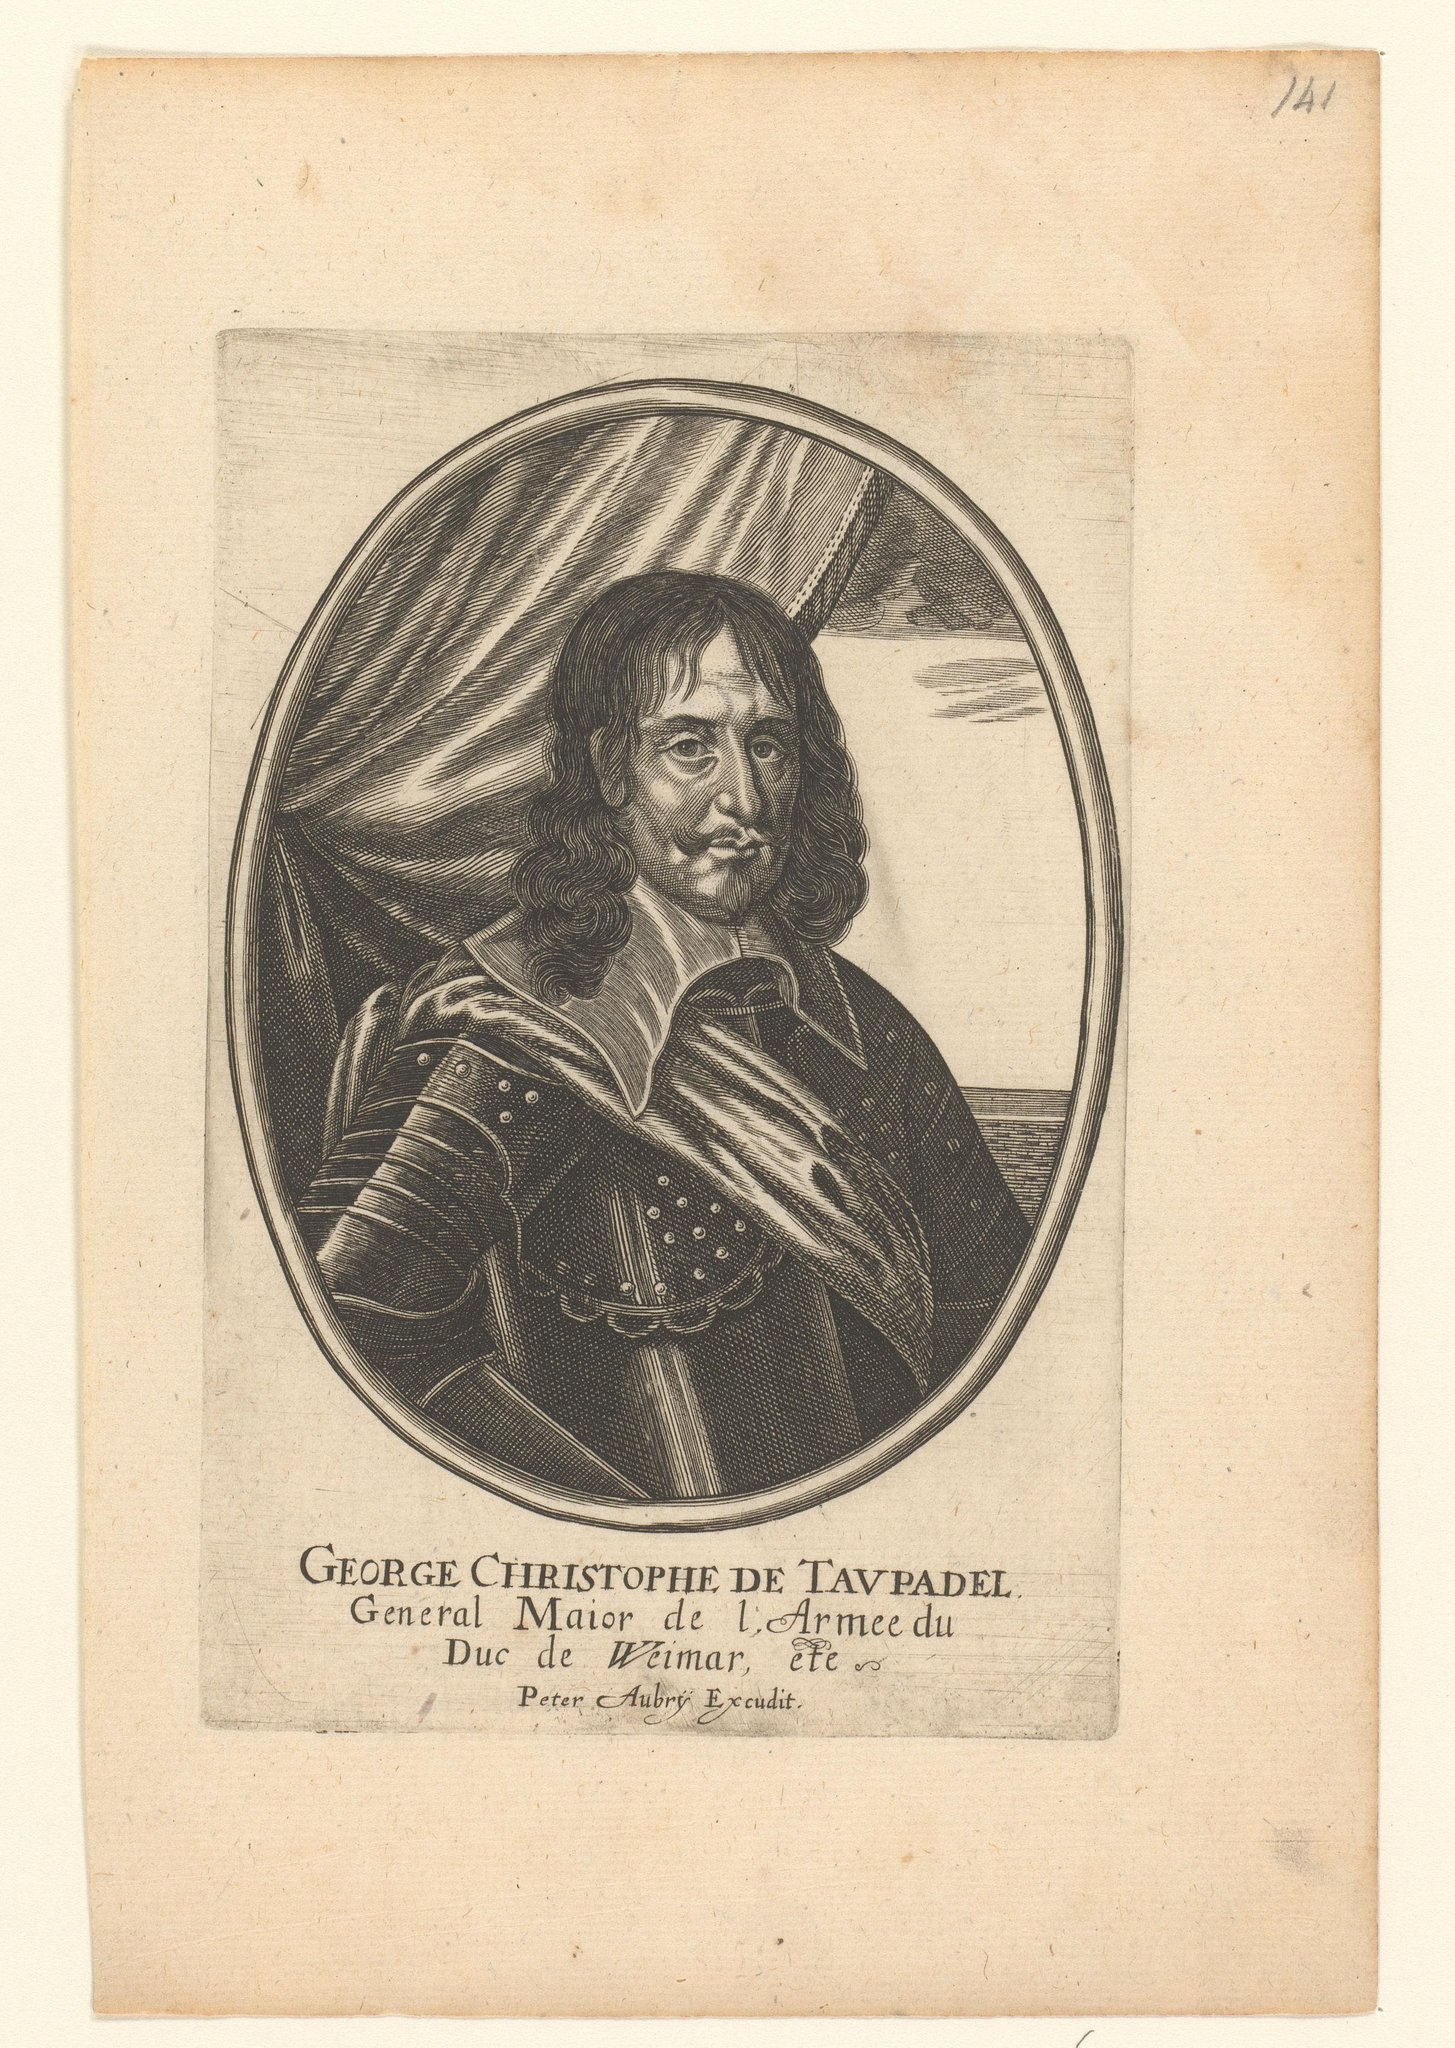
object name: print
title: Portret van George Christoph von Taupadel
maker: Anonymous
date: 1634-1686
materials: paper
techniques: engraving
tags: commander-in-chief, general, marshal, historical persons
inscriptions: collector's mark: Lugt 2228, number: ‘141’